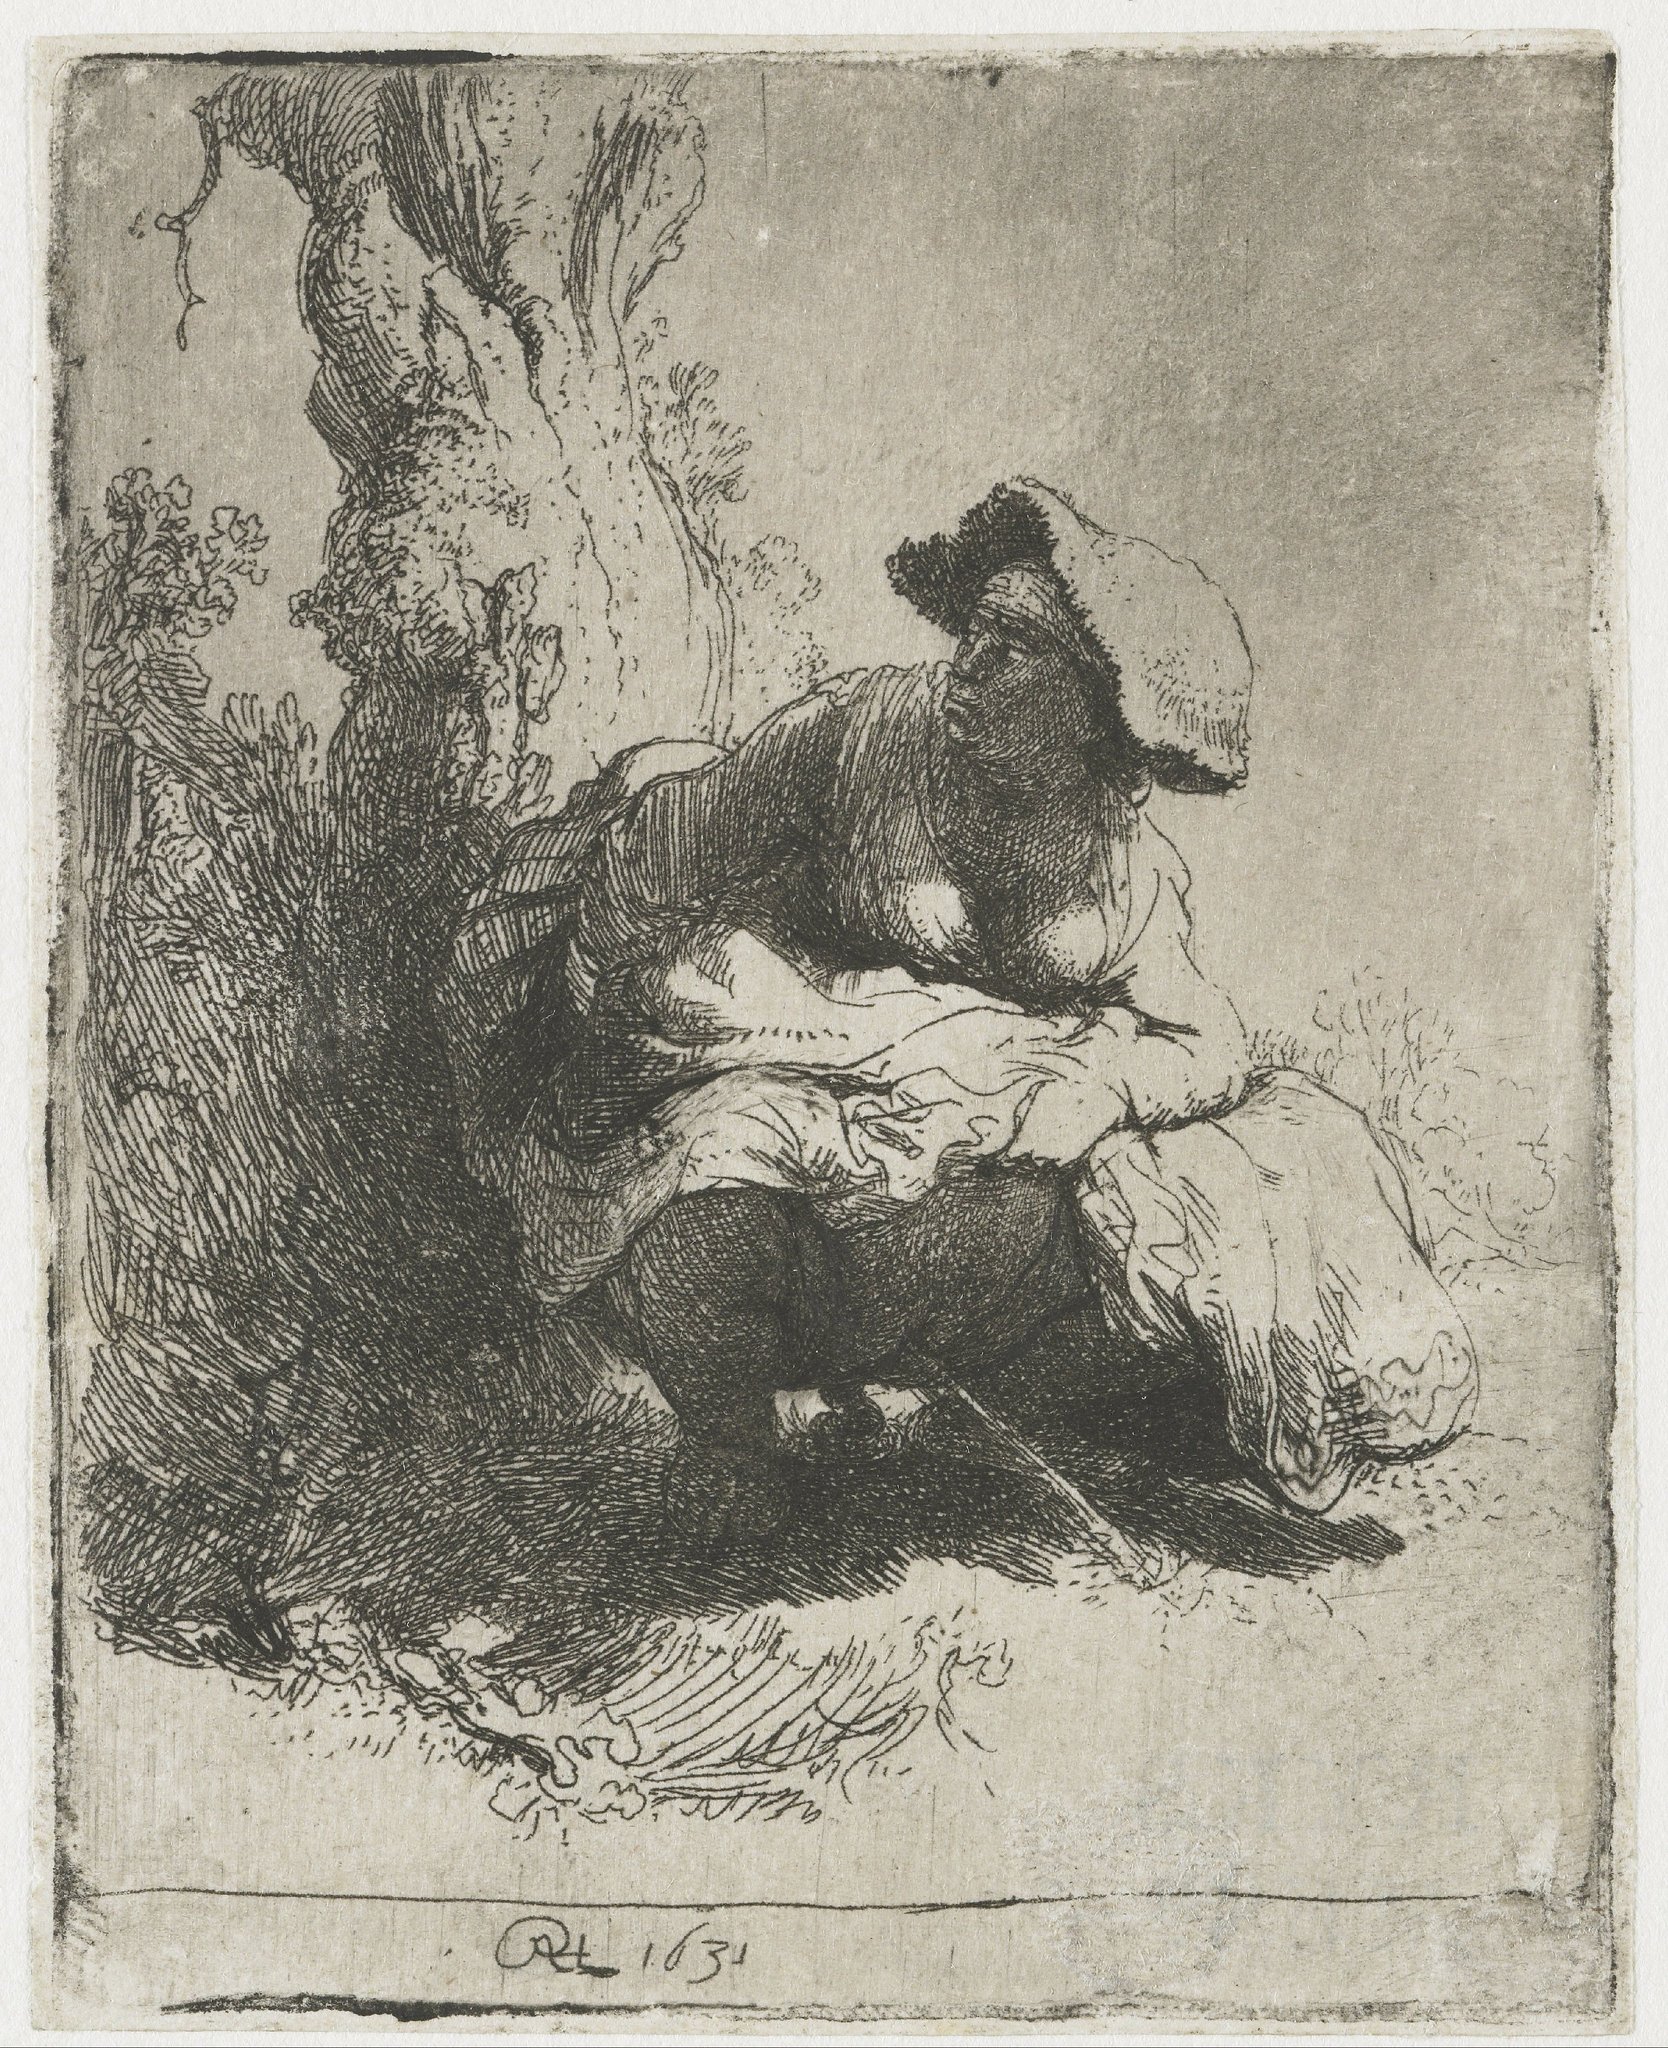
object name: print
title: A woman making water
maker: rembrandt van rijn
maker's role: draughtsman, painter, print maker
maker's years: 1606-1669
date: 1631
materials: paper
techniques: etching, intaglio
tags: urination, defecation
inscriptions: mark: 2165, monogram and date: ‘RHL 1631’ Lugt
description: Gehurkte vrouw doet haar behoefte op de grond.